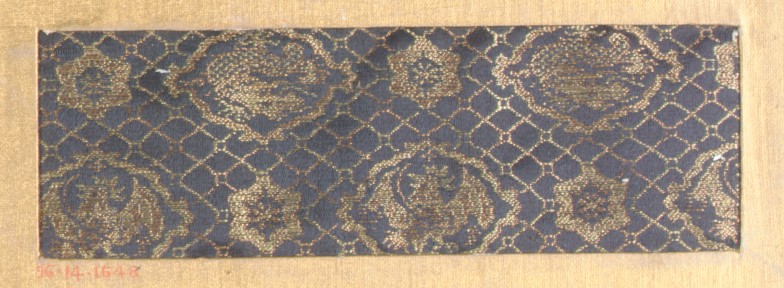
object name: piece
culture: japanese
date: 1701-1900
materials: silk